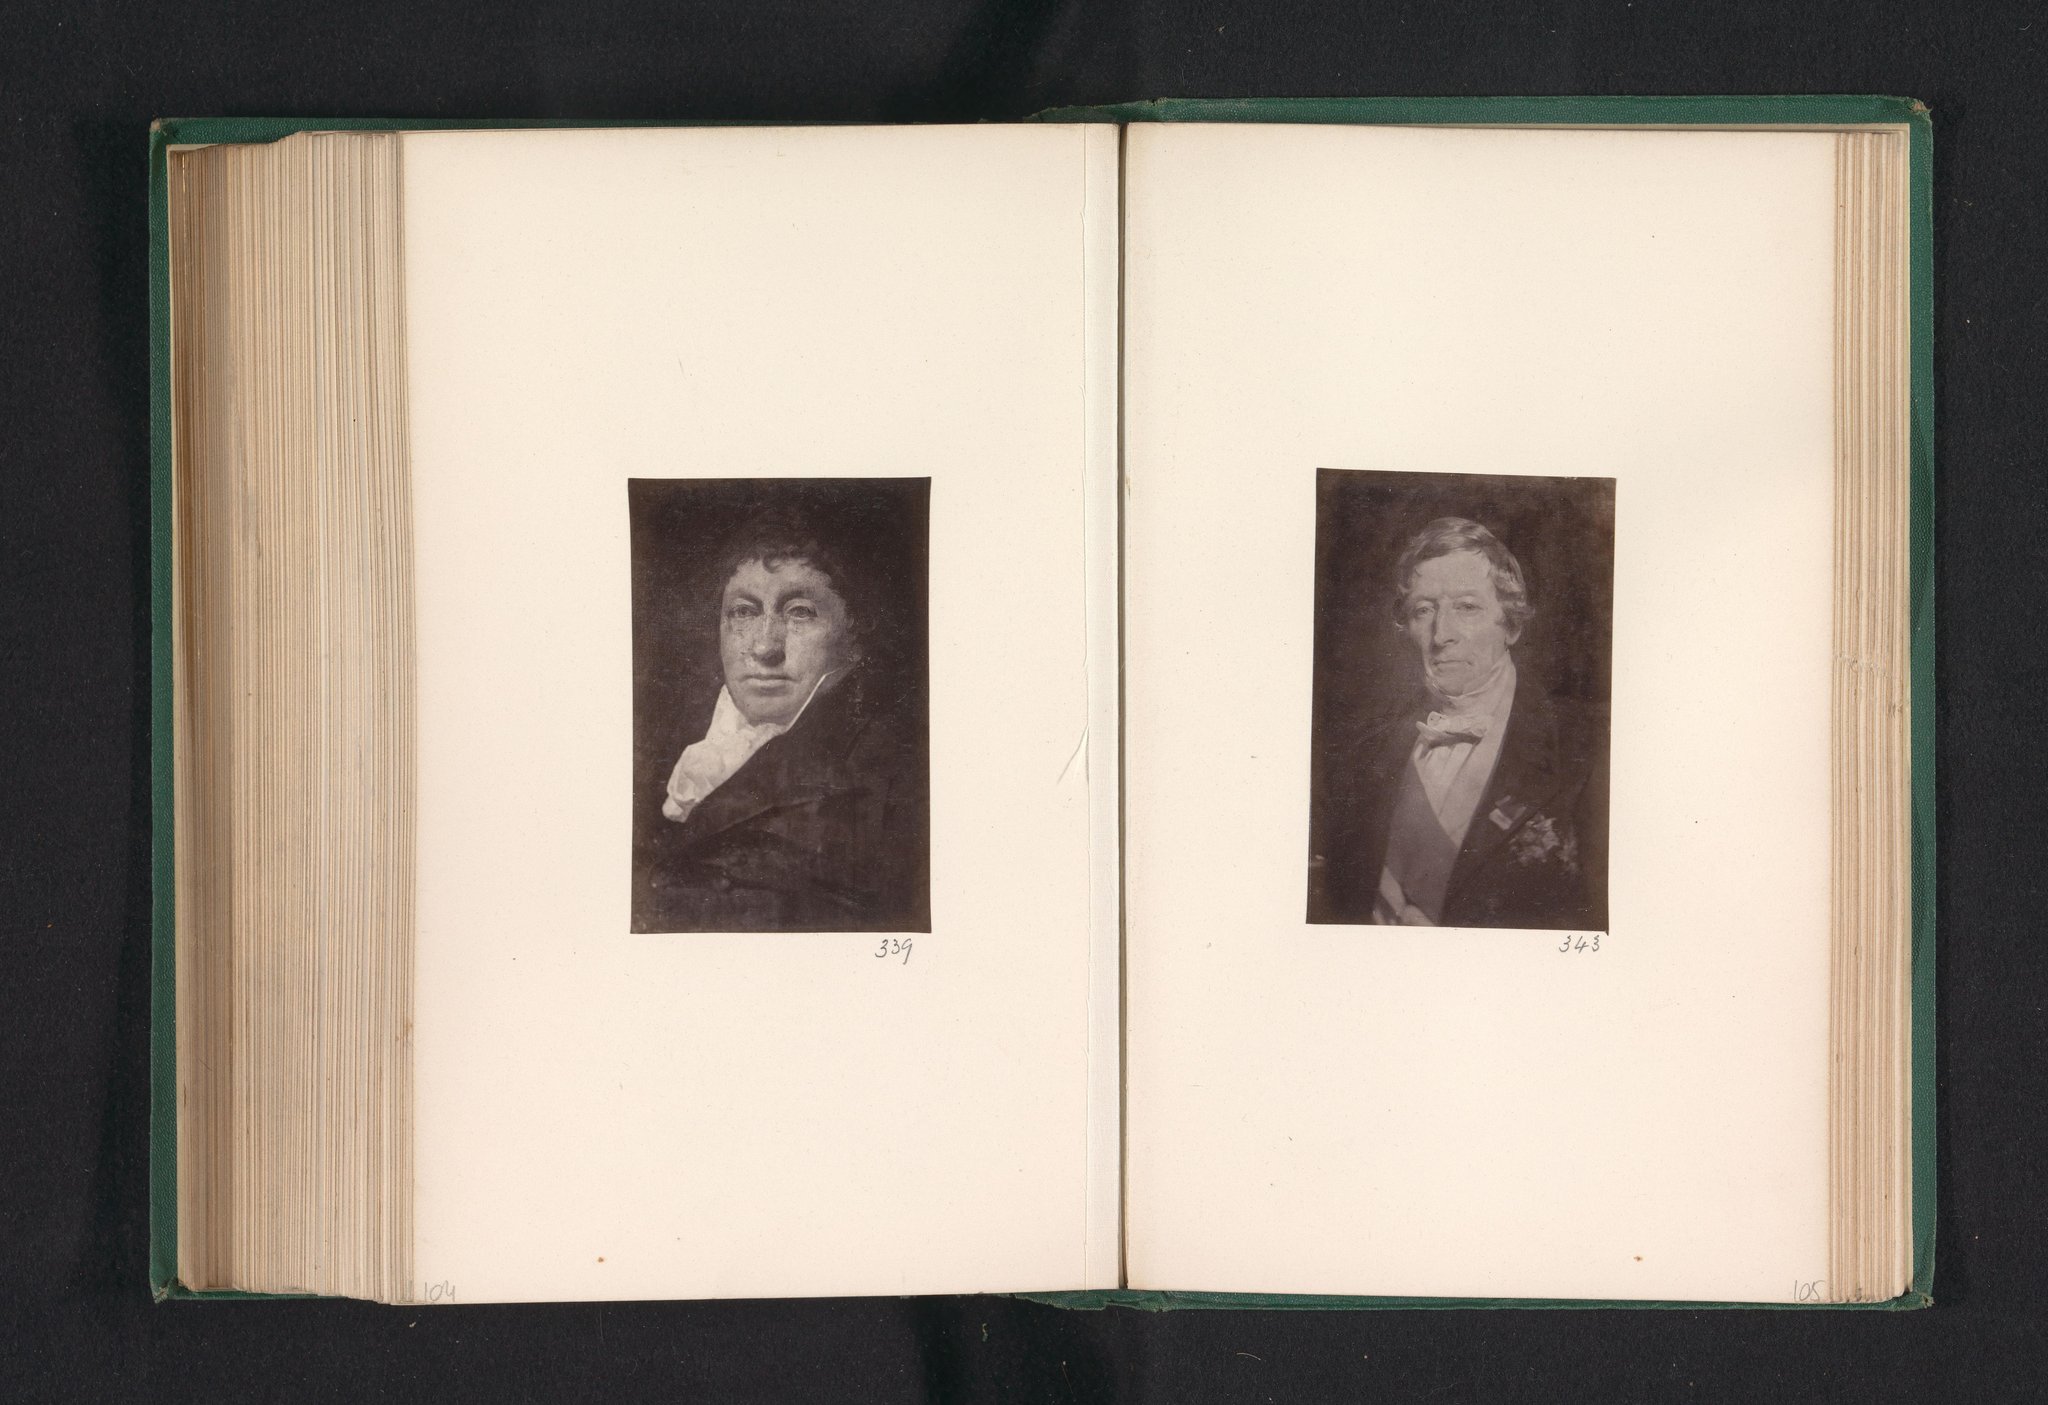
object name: reproduction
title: Fotoreproductie van een schilderij, voorstellende een portret van John Gordon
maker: thomas annan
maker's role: fotograaf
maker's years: 1829-1887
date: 1863-1868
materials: photographic support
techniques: albumen print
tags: historical persons (portraits and scenes from the life) (+ (full) bust portrait)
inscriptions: number: ‘339’